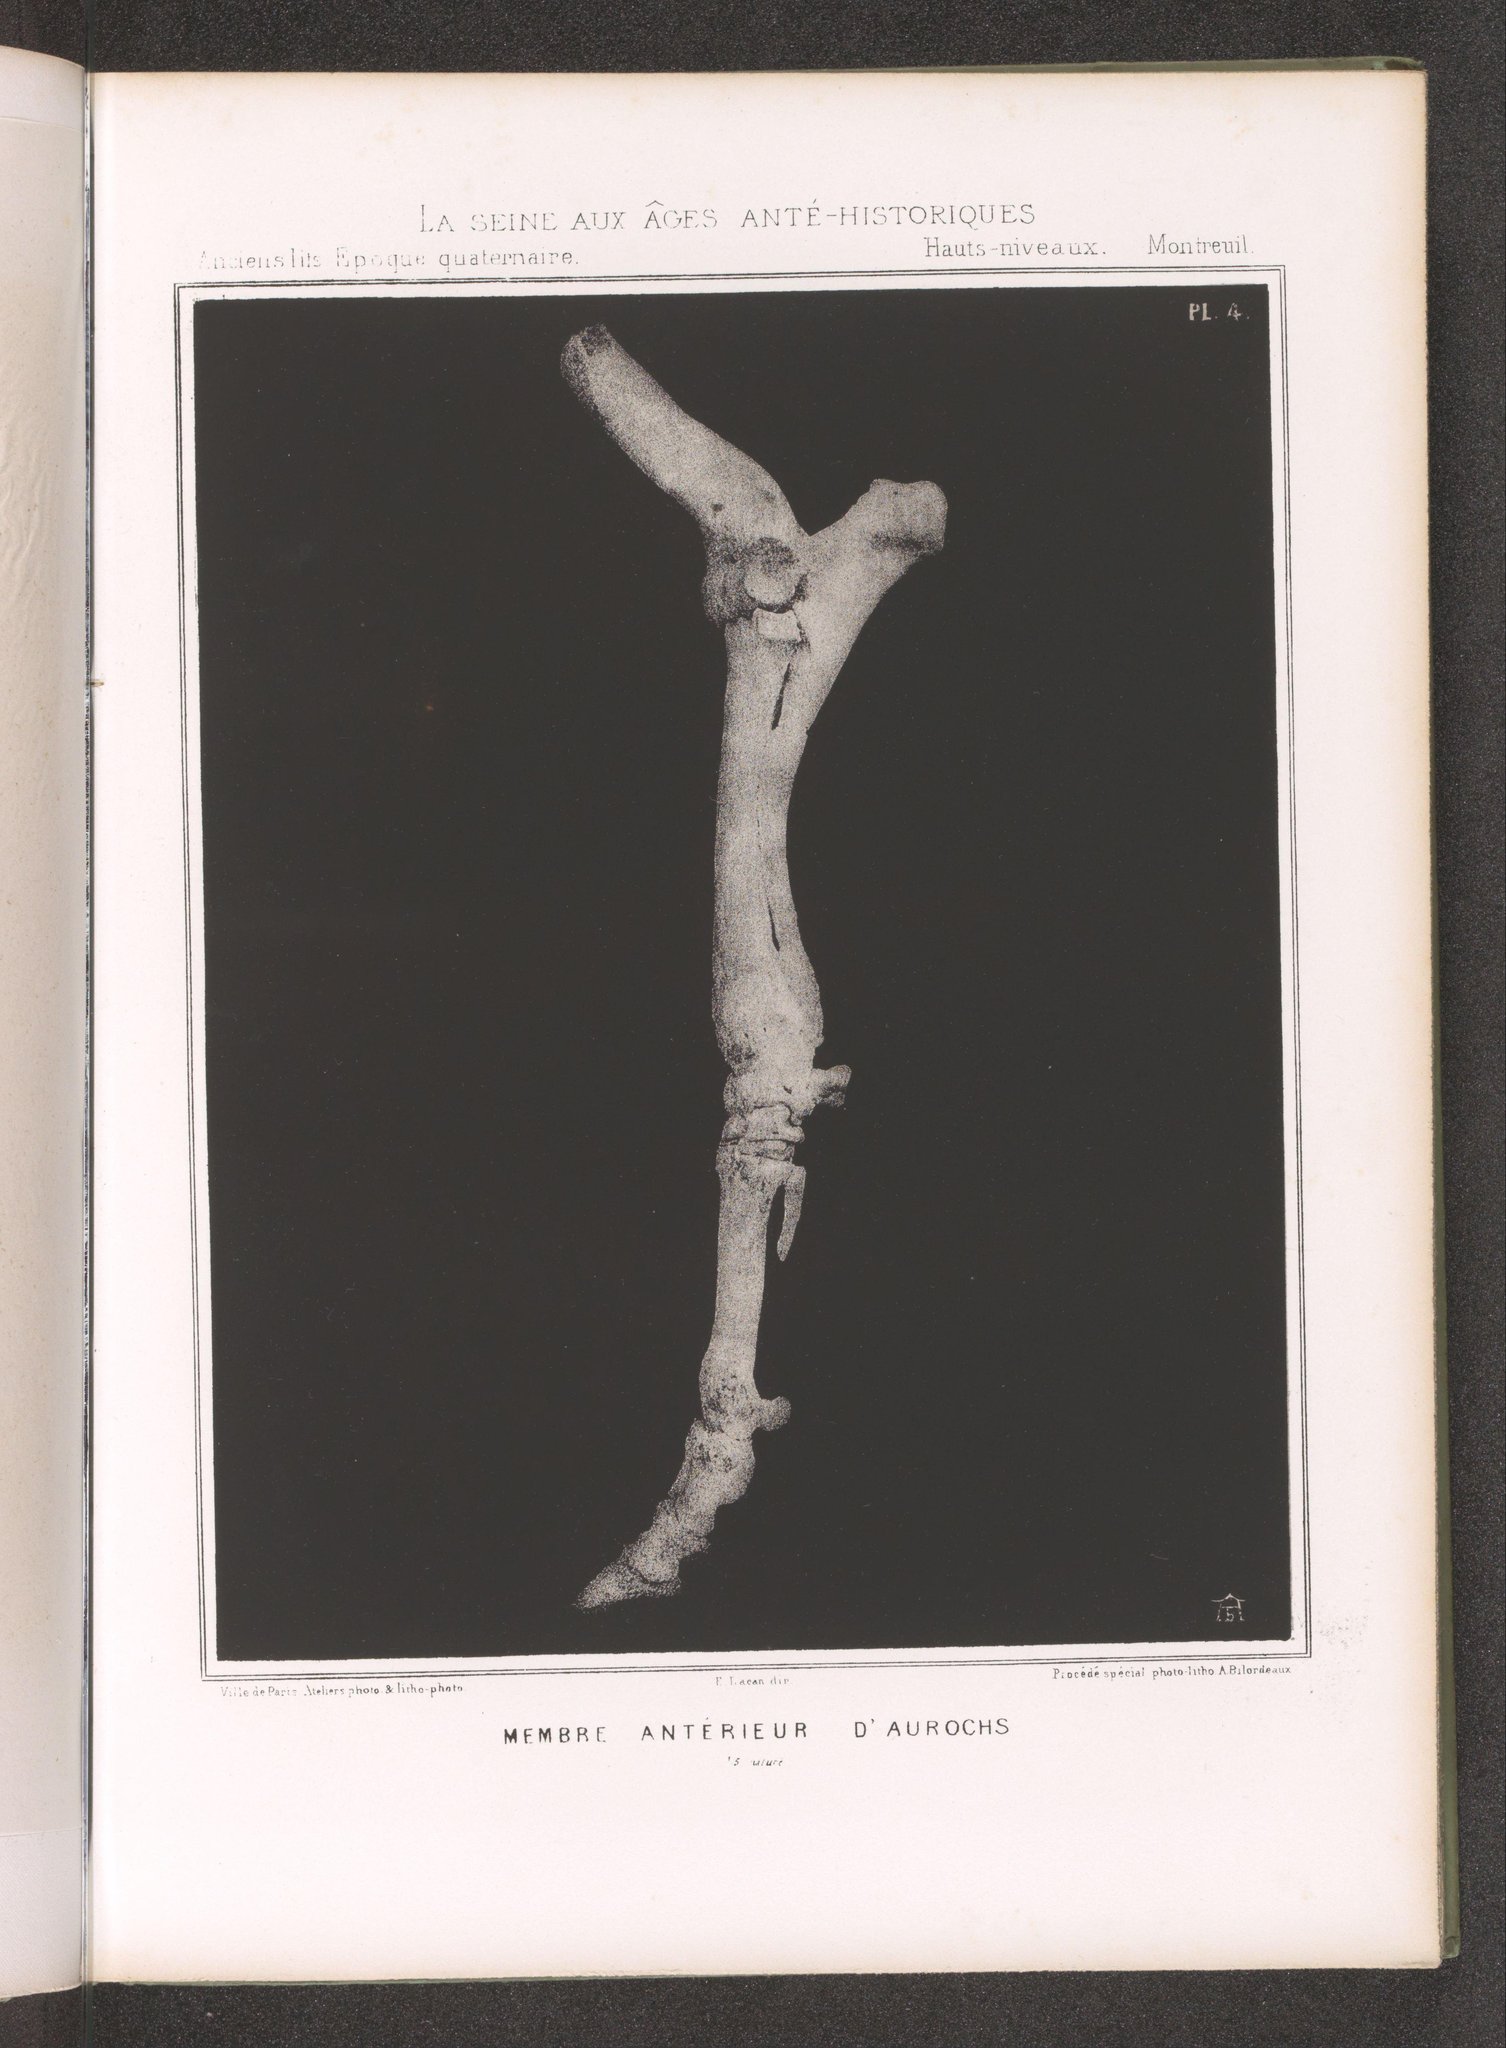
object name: page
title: Botten uit een voorpoot van een oeros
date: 1860-1869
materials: paper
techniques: photolithography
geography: france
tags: animals (+ skeleton of an animal), palaeontology, france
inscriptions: monogram: ‘AB’, number: ‘Pl. 4’, inscription: ‘Ville de Paris Ateliers photo & litho photo E. Lacan, dir. Procédé spécial photo-litho A. Bilordeaux’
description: Voor plek prent in boek: zie nummer onder 'Opschriften / Merken'.